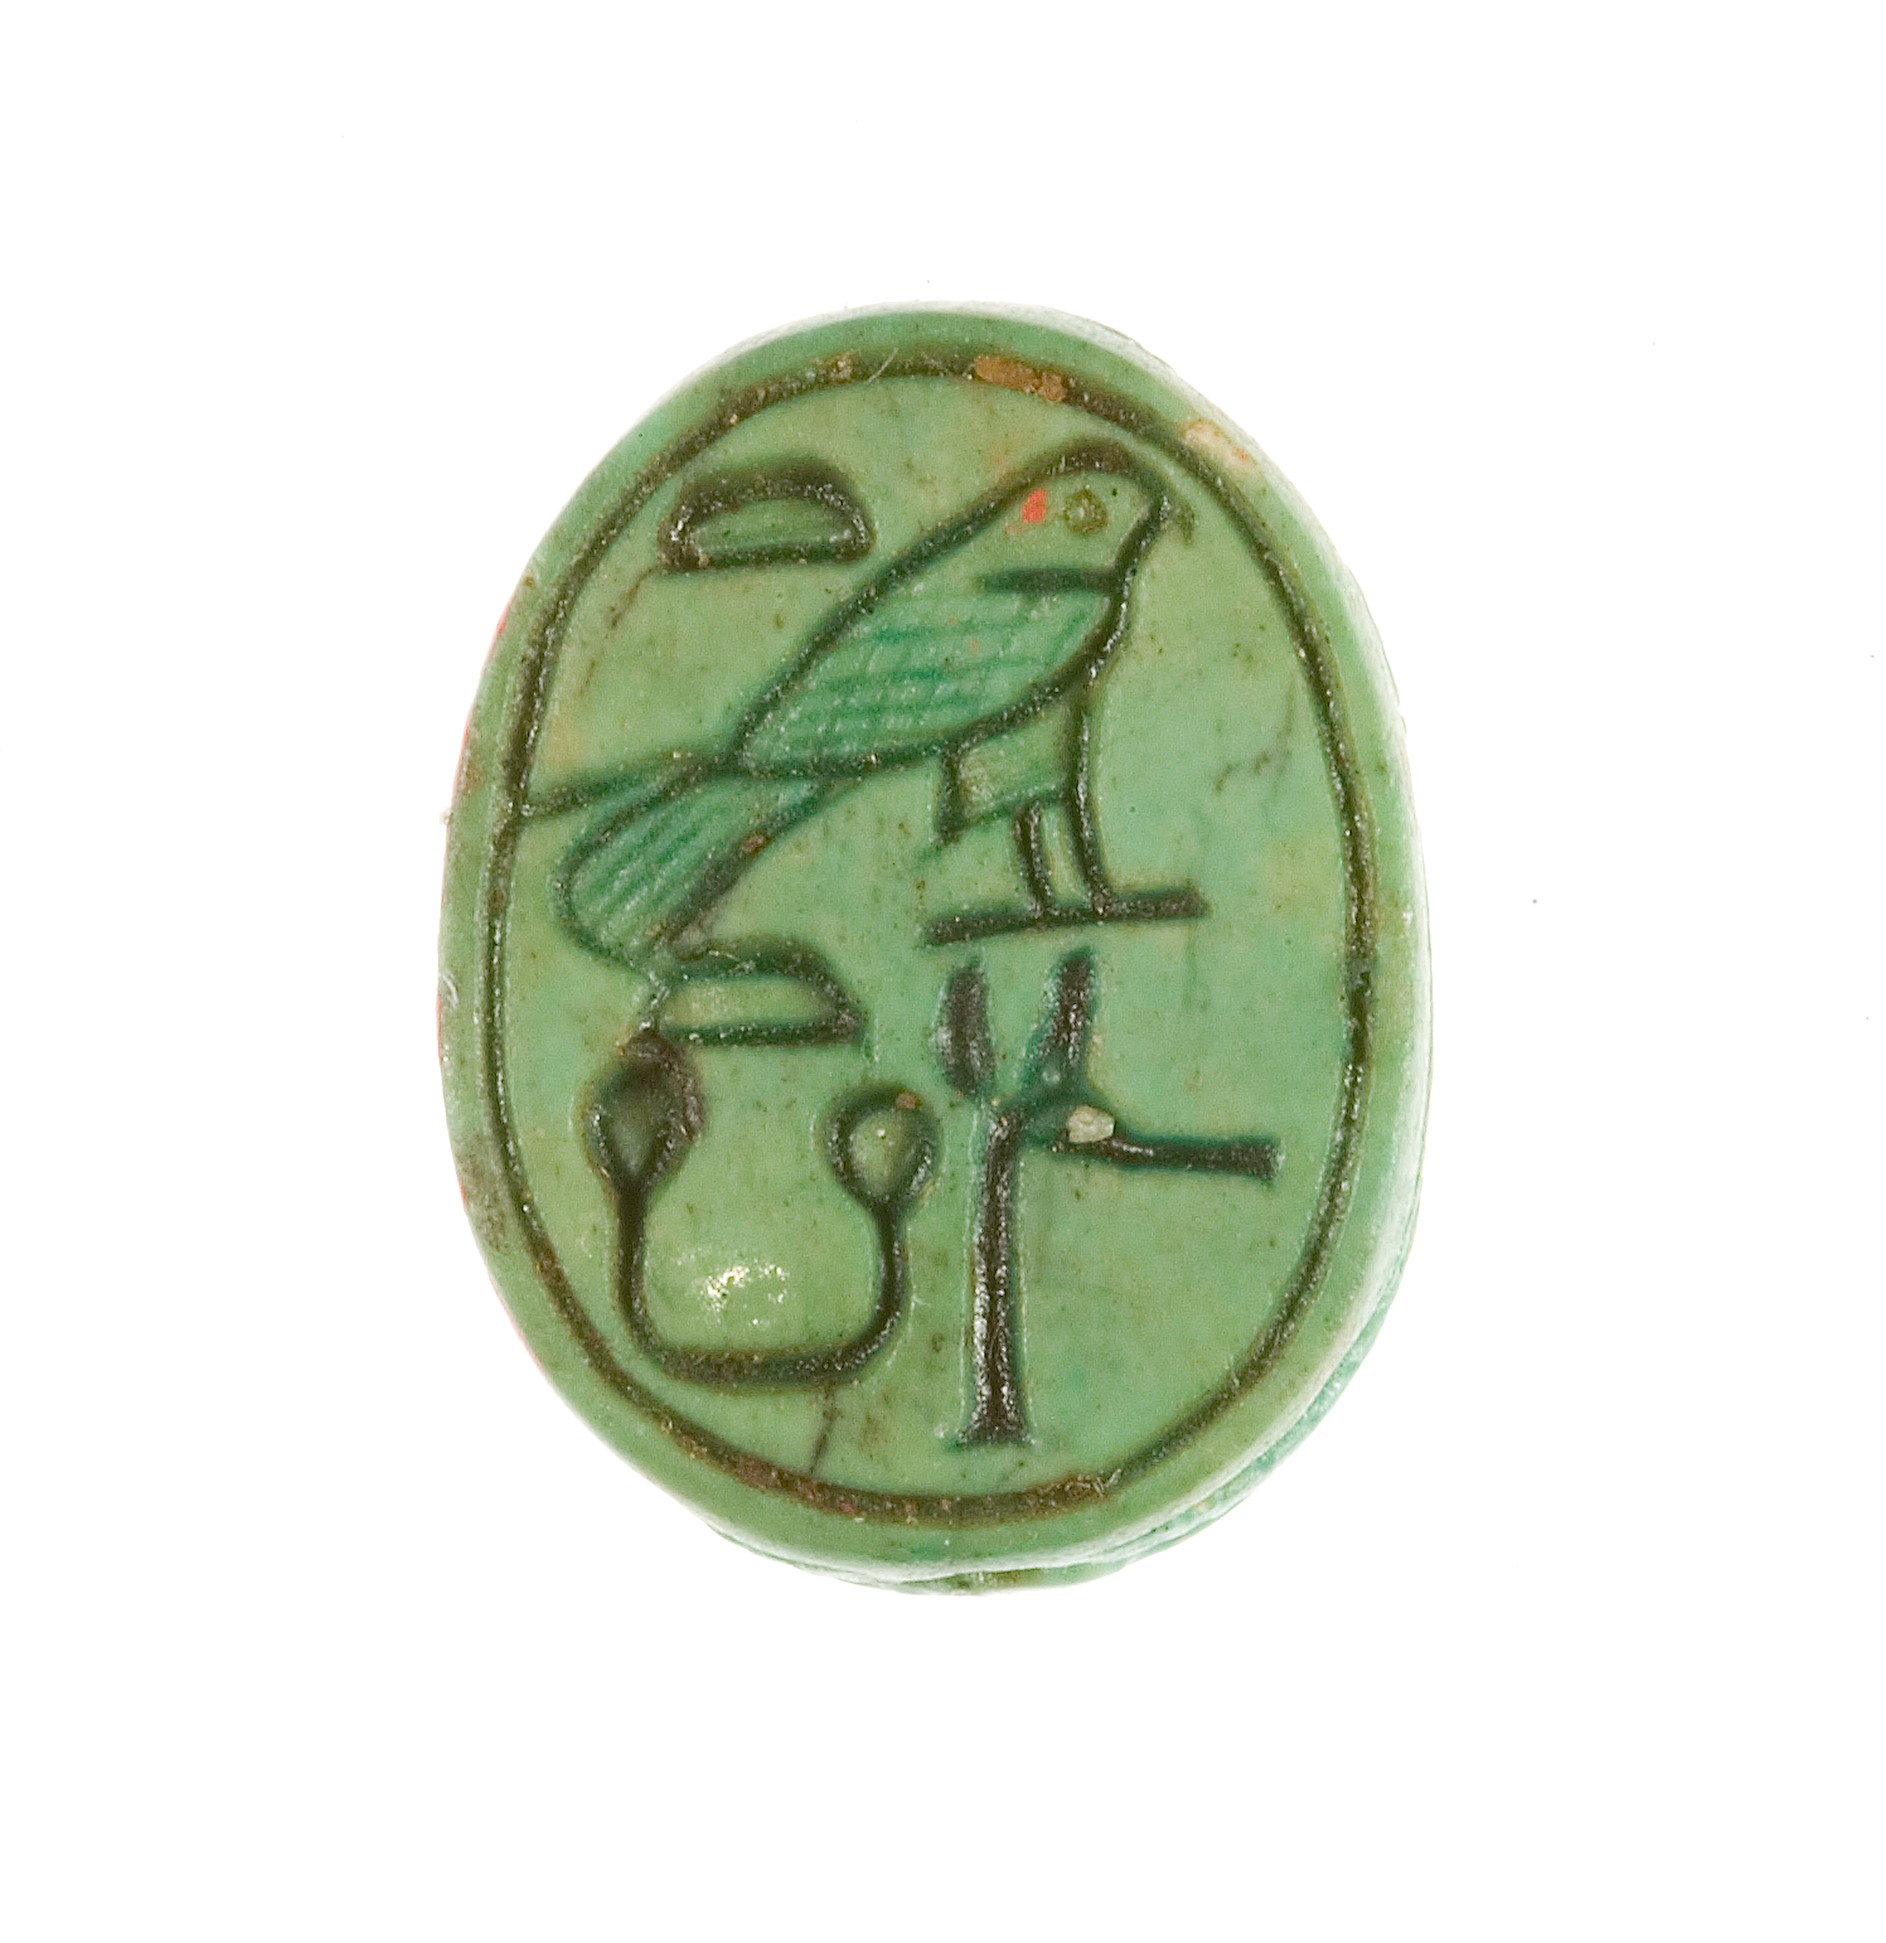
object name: scarab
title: Scarab Inscribed for the Female Horus Wosretkau (Hatshepsut)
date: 1479-1458 BCE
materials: stone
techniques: glazing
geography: egypt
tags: birds,scarabs